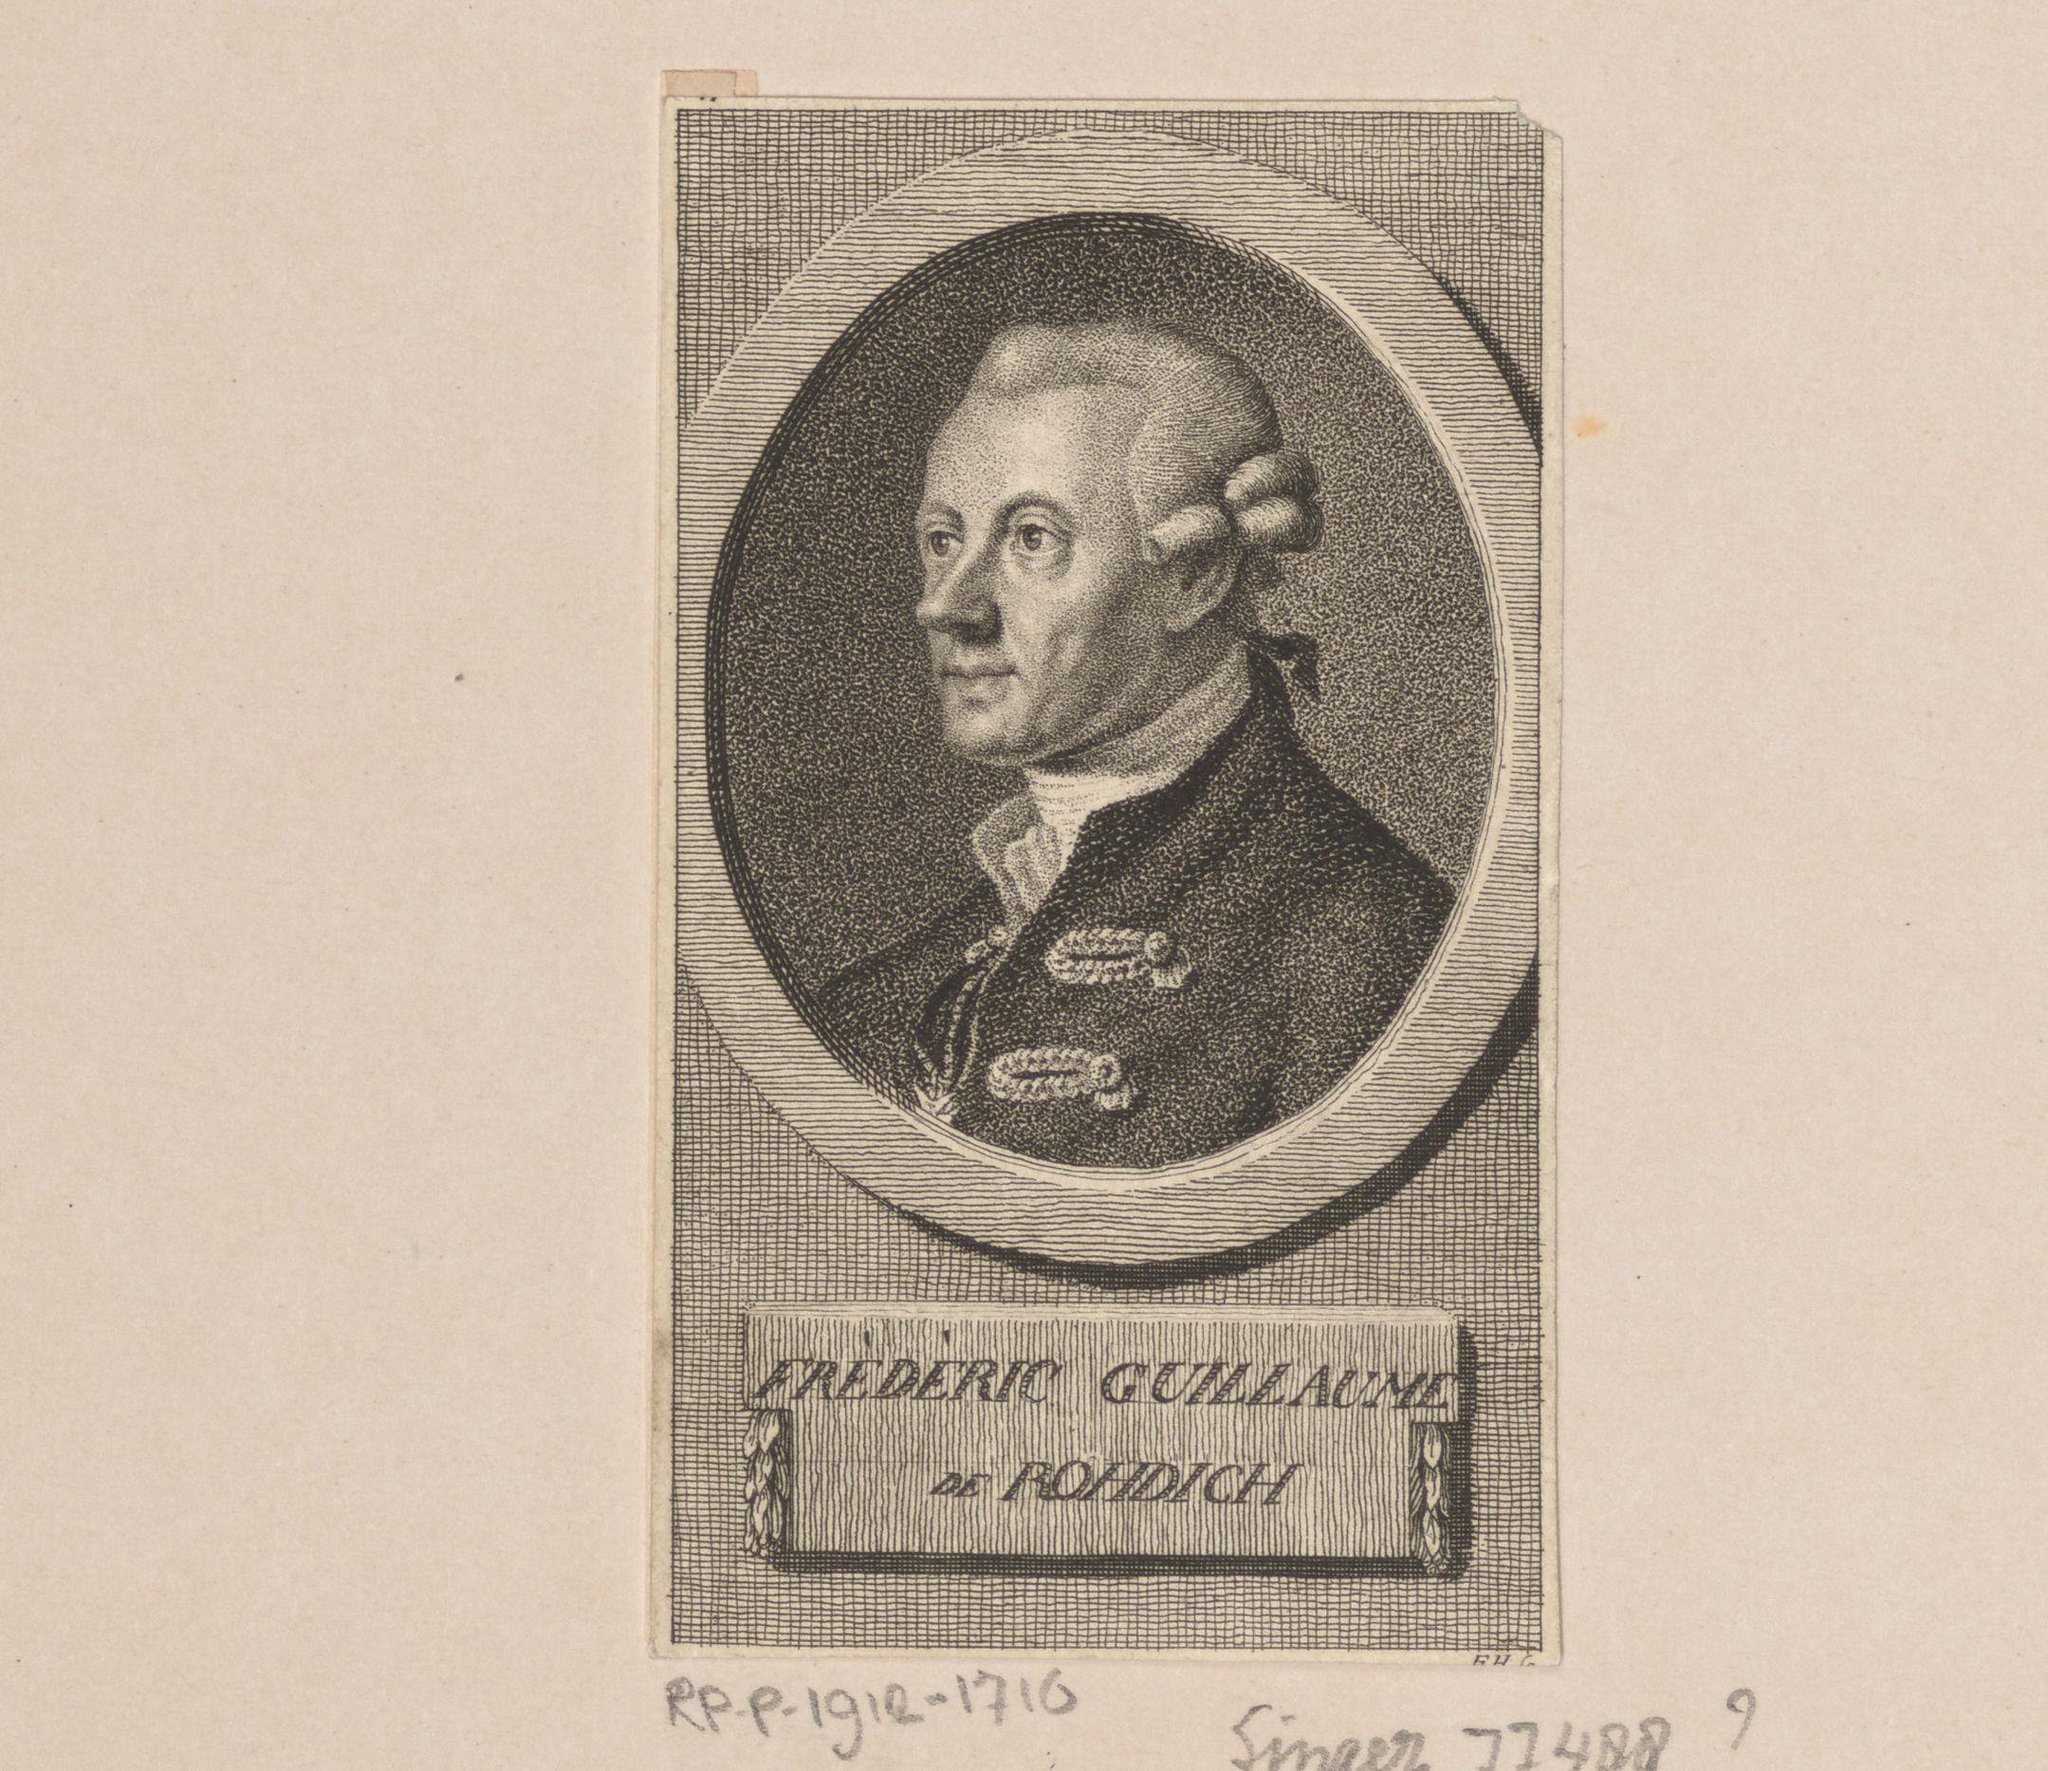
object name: print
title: Portret van Friedrich Wilhelm von Rohdich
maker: eberhard siegfried henne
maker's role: print maker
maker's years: 1759-1828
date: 1769-1828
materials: paper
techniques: etching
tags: historical persons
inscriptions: collector's mark: Lugt 2228